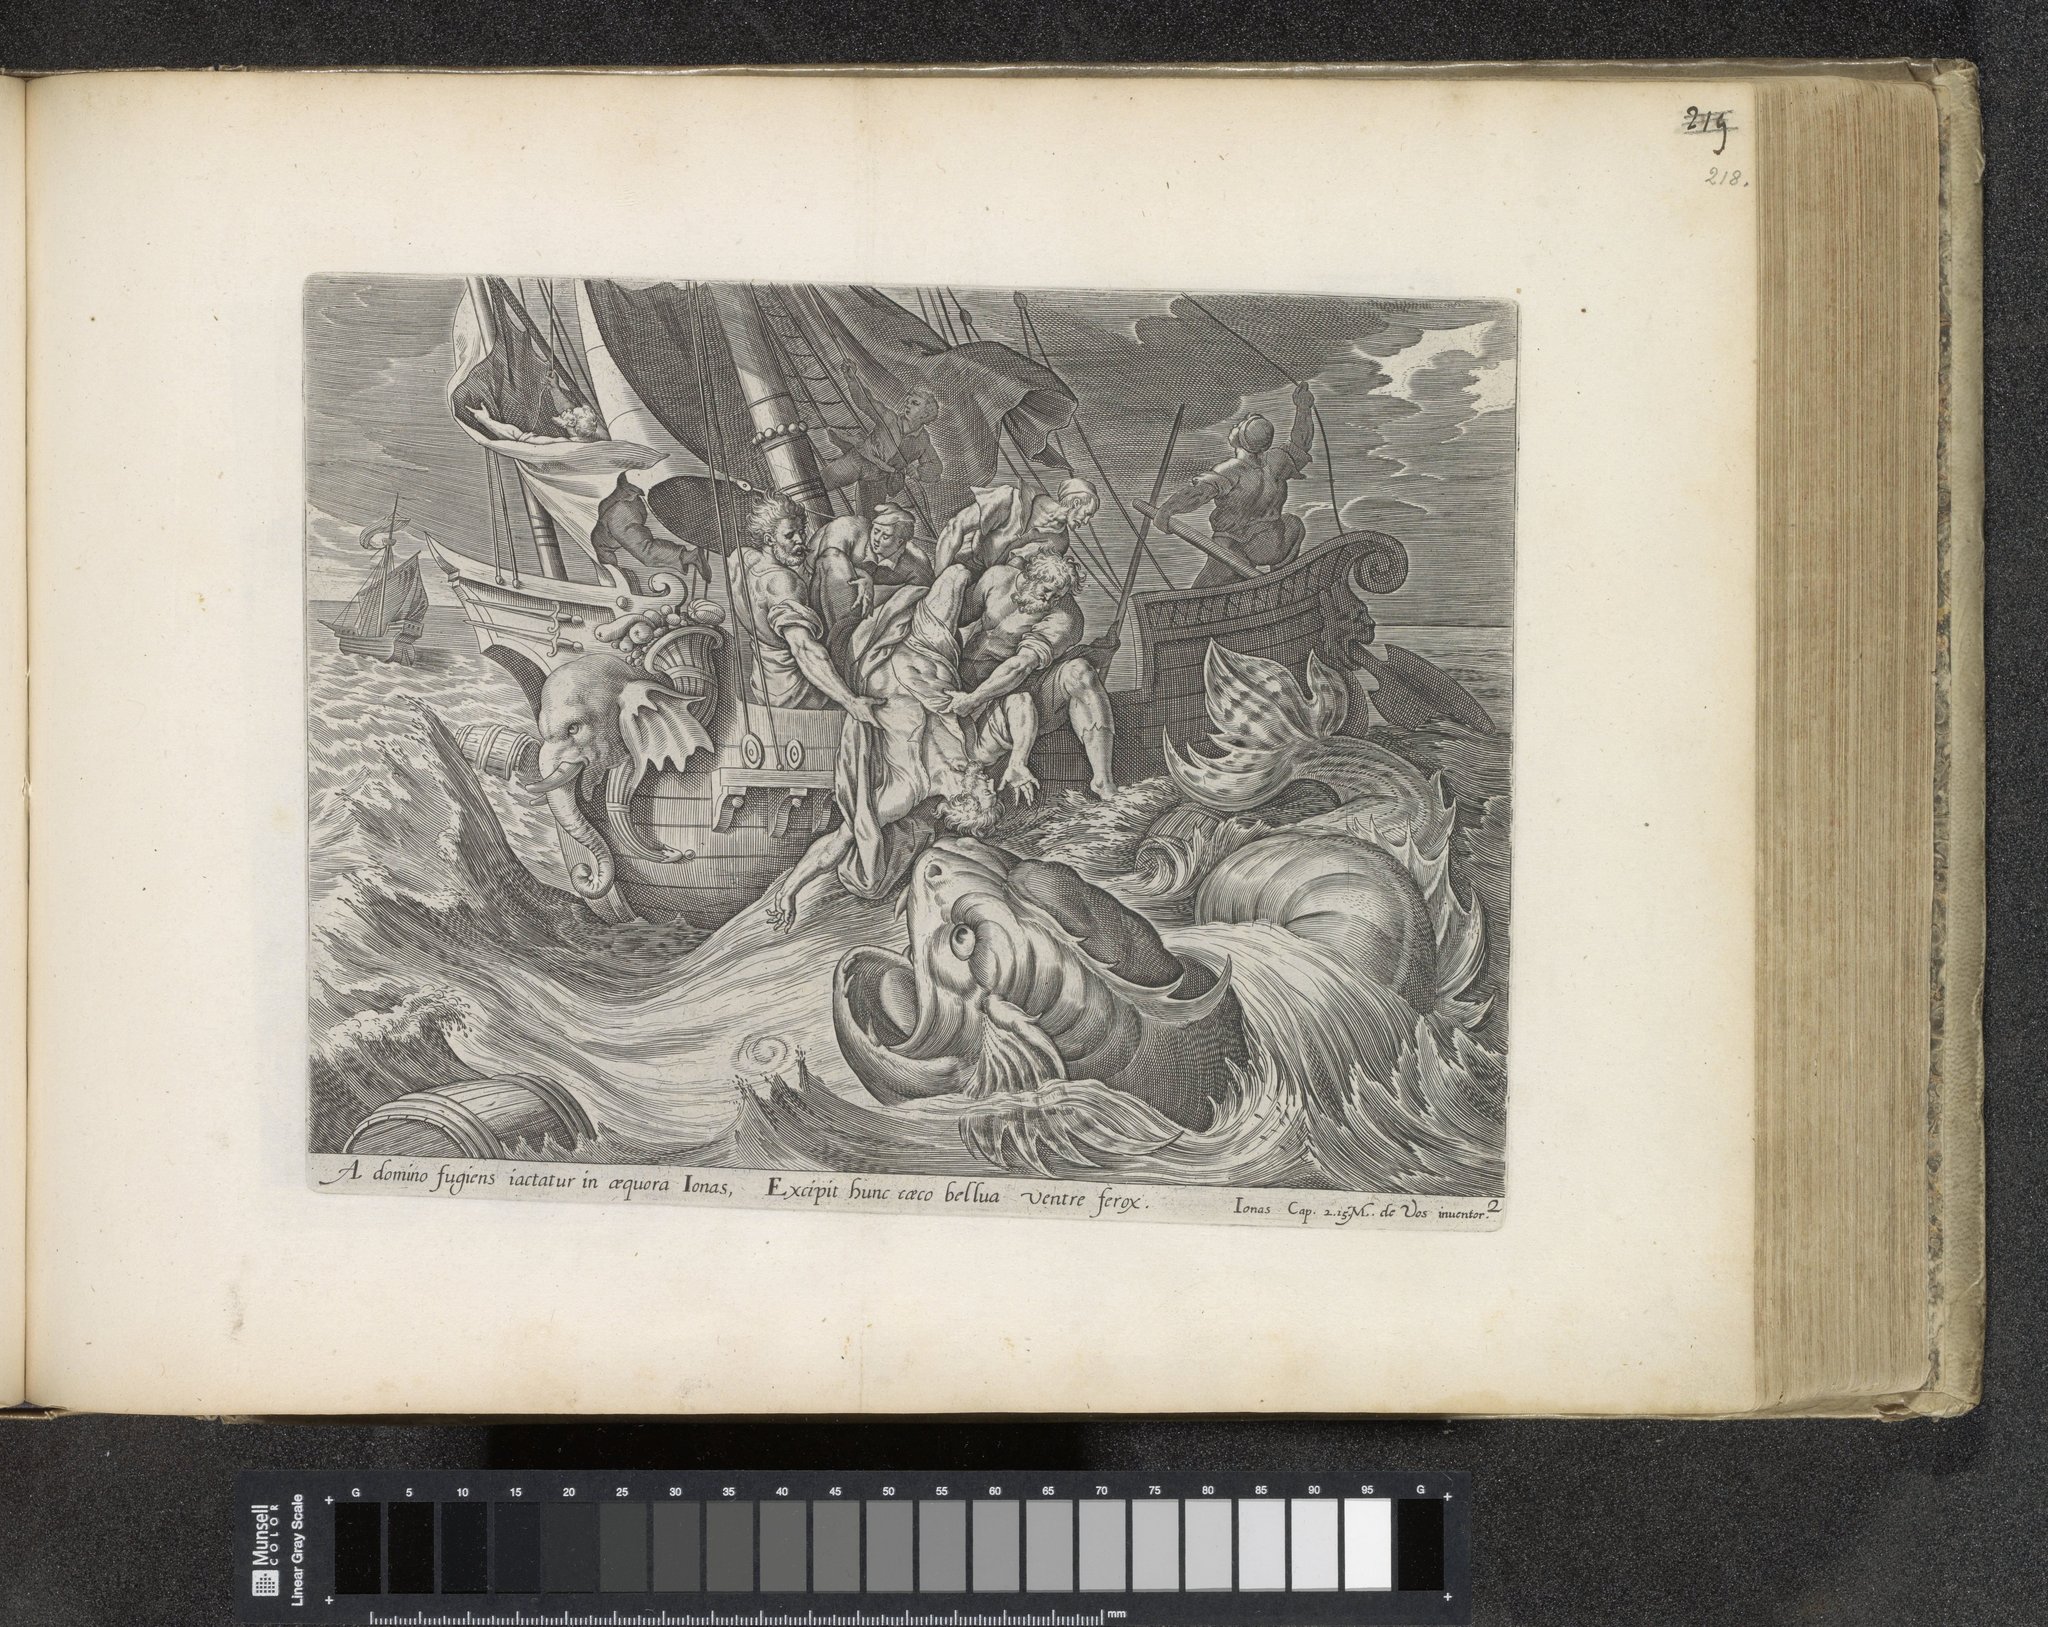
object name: album leaf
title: Jona overboord gezet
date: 1585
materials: paper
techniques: engraving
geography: amsterdam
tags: the sailors reluctantly throw the prophet jonah into the sea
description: Als het schip waarop Jona is gevlucht dreigt te vergaan in een storm, wordt Jona door loting aangewezen als de schuldige. Hij wordt door de bemanning overboord gegooid. Op de voorgrond zwemt de vis, die Jona zal opslokken. Onder de voorstelling een verwijzing in het Latijn naar de Bijbeltekst in Jona 2:15. Deze prent maakt deel uit van een album.